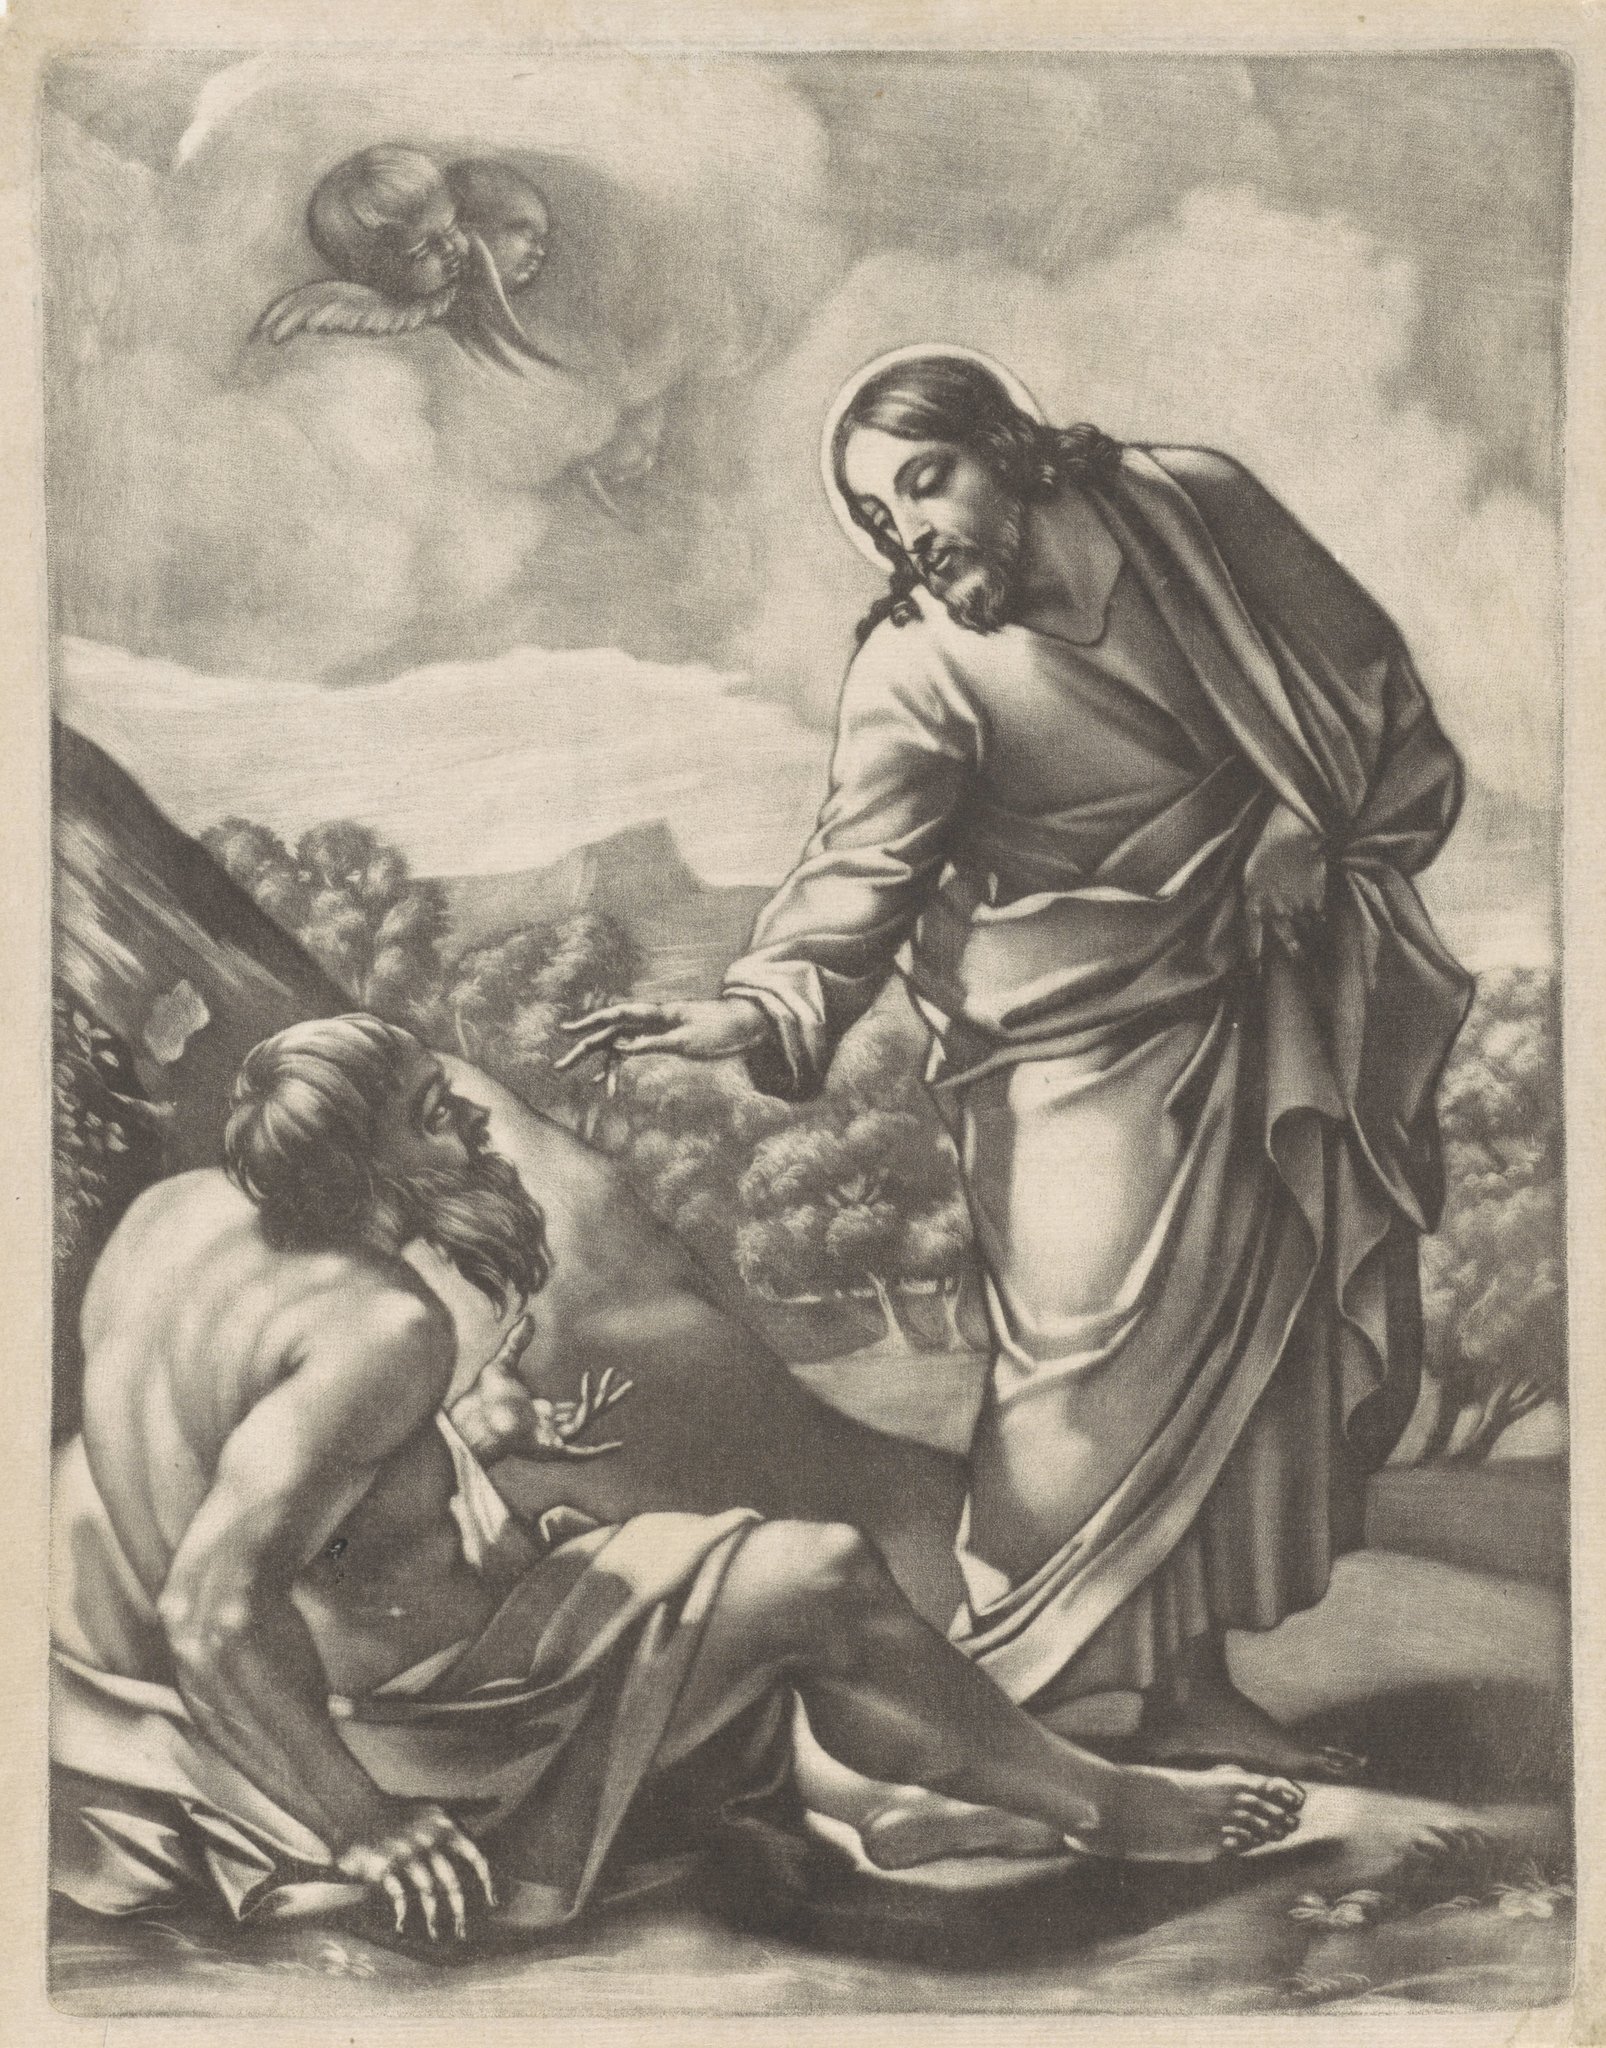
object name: print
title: Christus geneest een verlamde man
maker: Anonymous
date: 1650-1800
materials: paper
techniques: mezzotint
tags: a paralytic on his bed is brought to the house where christ is preaching (matthew 9:1-8; mark 2:1-12; luke 5:17-26)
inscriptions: collector's mark: Lugt 2228